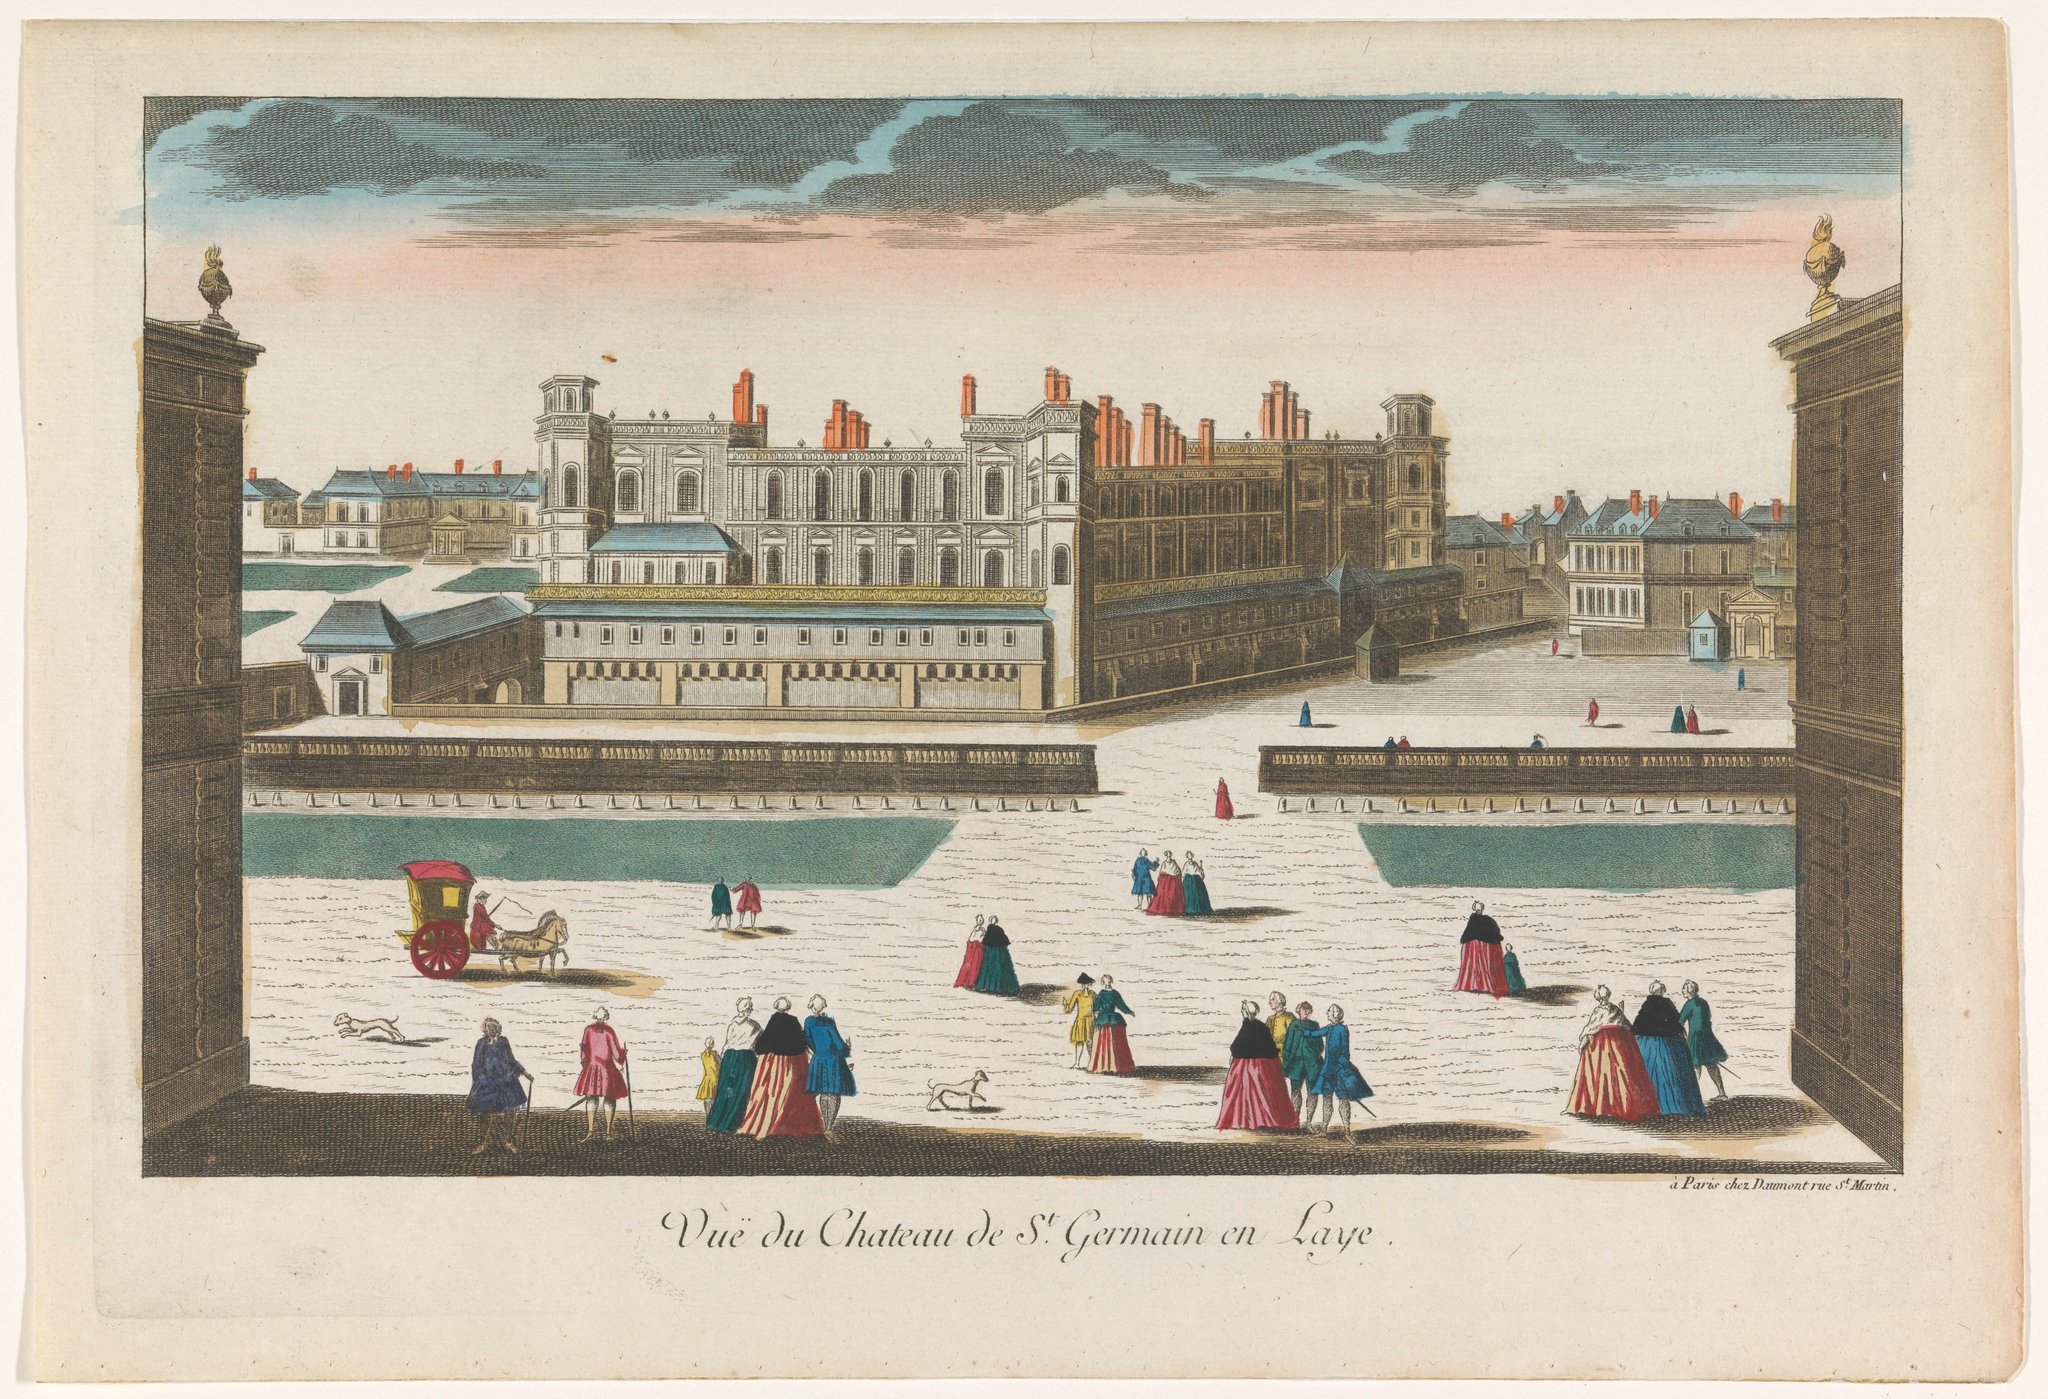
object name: opticaprent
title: Vuë du Chateau de St. Germain en Laye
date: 1745-1775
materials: paper, watercolor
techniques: brush, etching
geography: paris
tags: civic architecture; edifices; dwellings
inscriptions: collector's mark: Lugt 2166, watermark